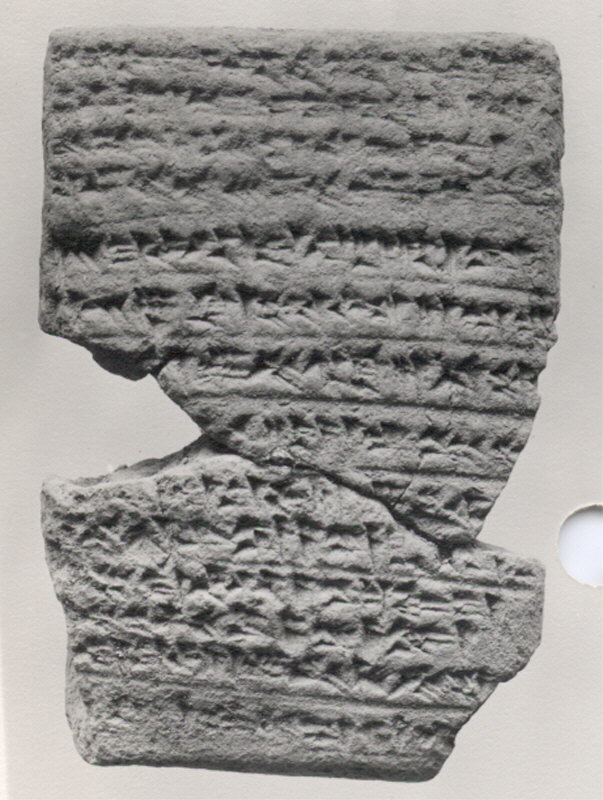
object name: cuneiform tablet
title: Cuneiform tablet: account of date disbursements to prebendary brewers, Ebabbar archive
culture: babylonian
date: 570 BCE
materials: clay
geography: mesopotamia